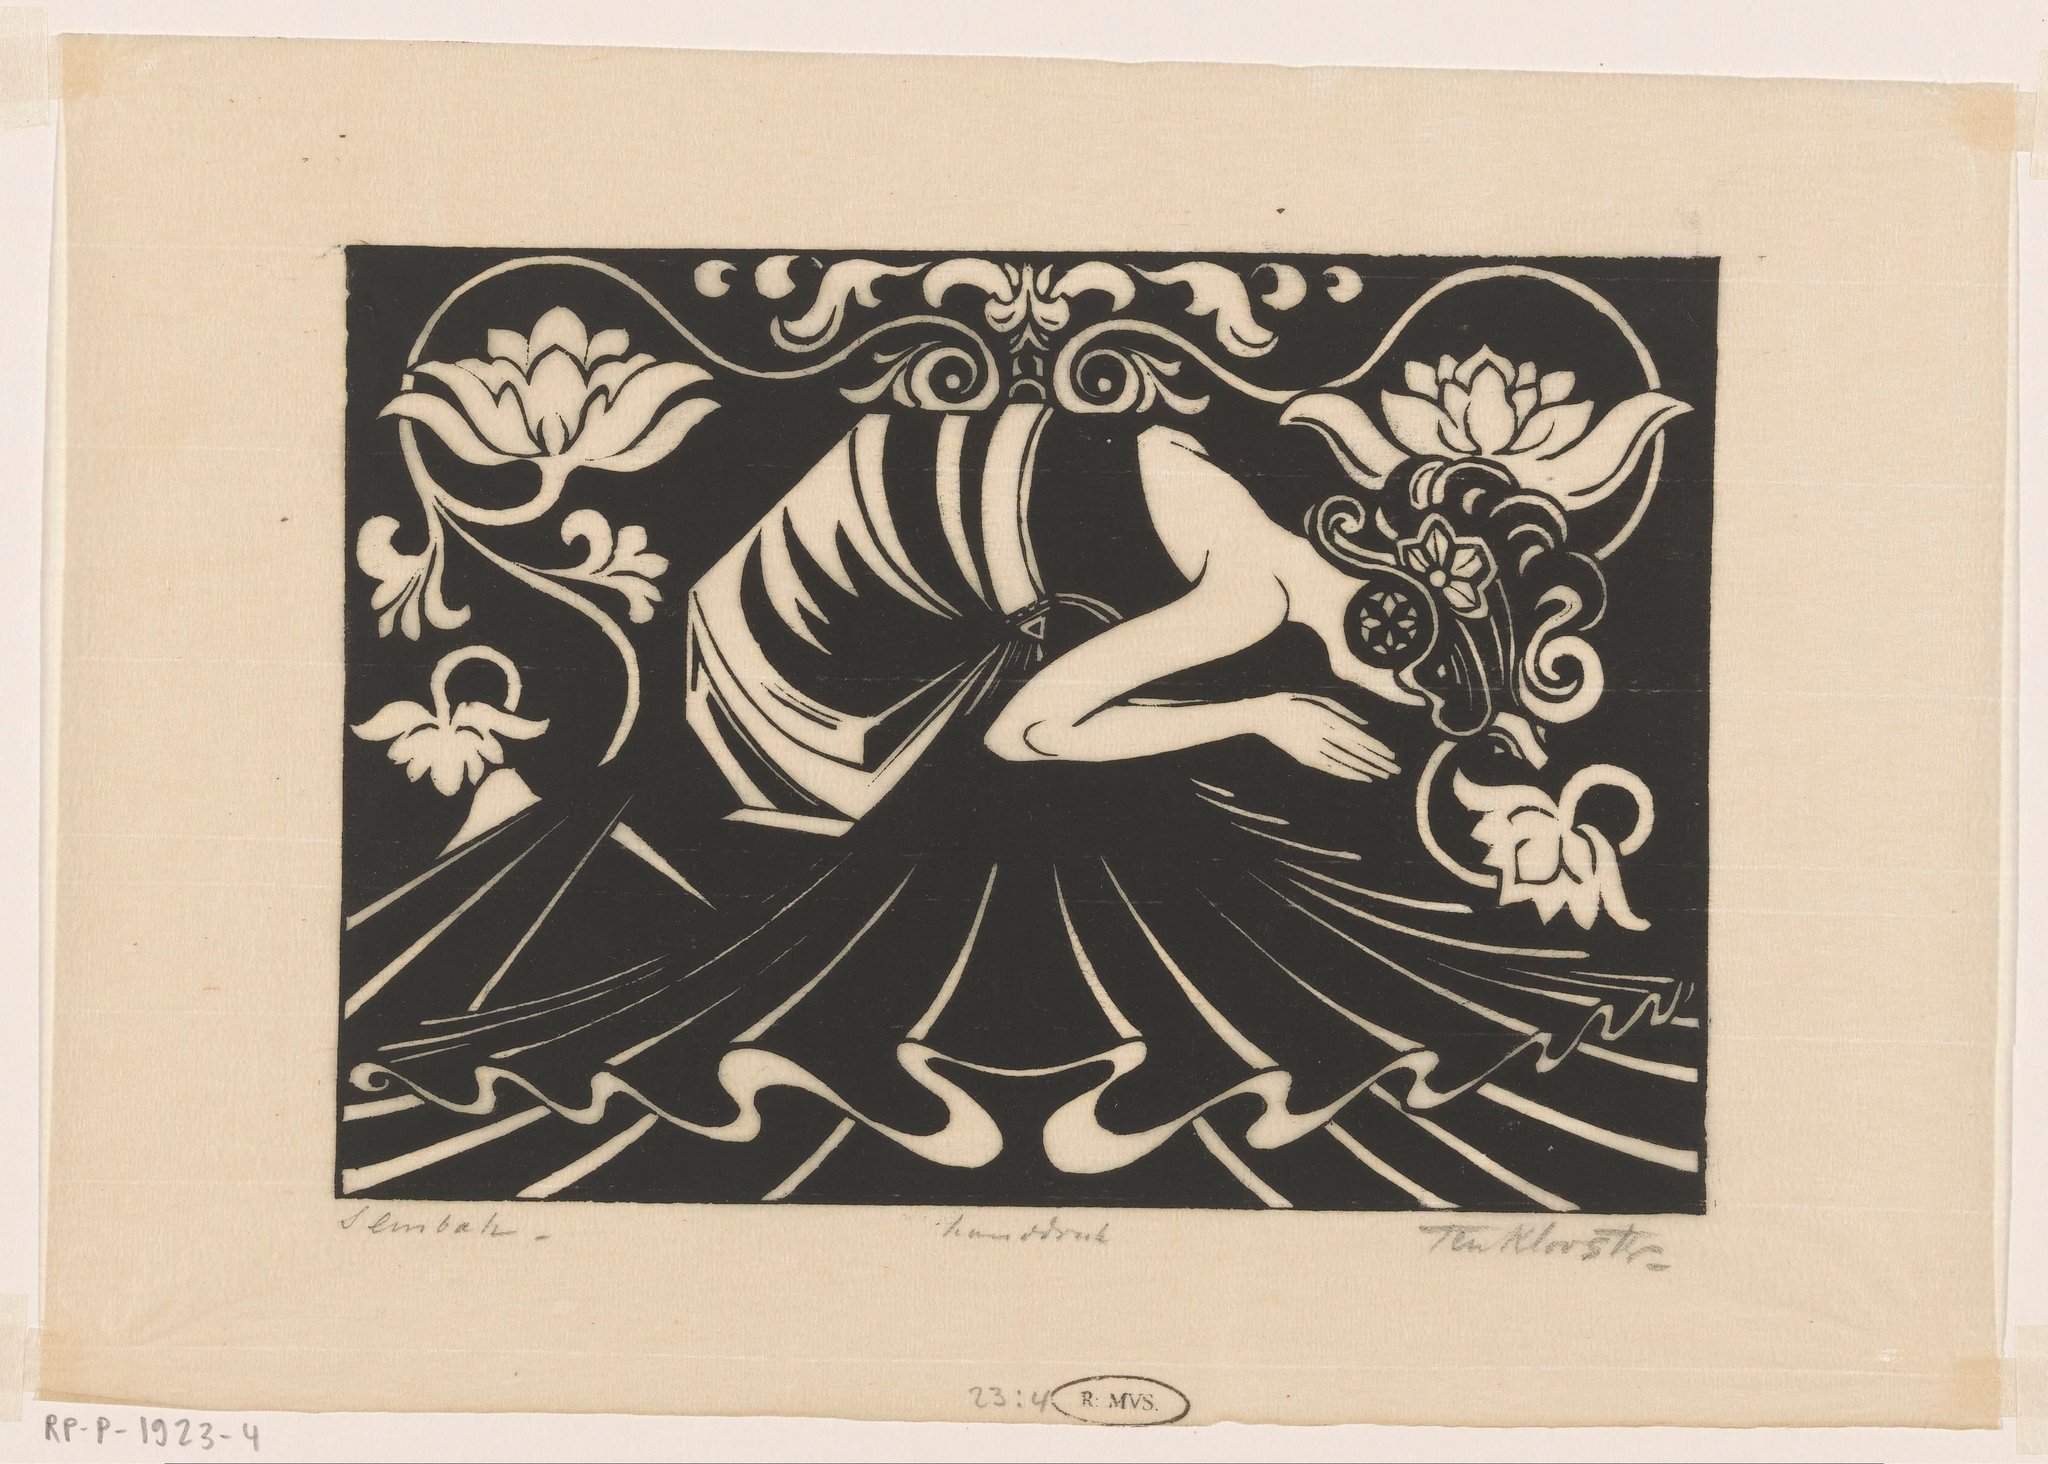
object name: print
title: Sembah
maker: johannes frederik engelbert ten klooster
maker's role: draughtsman, print maker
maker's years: 1873-1940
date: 1922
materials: paper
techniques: woodcut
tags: kneeling figure - aa - female human figure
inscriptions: collector's mark: Lugt 2228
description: Een knielende vrouw met samengevouwen handen.